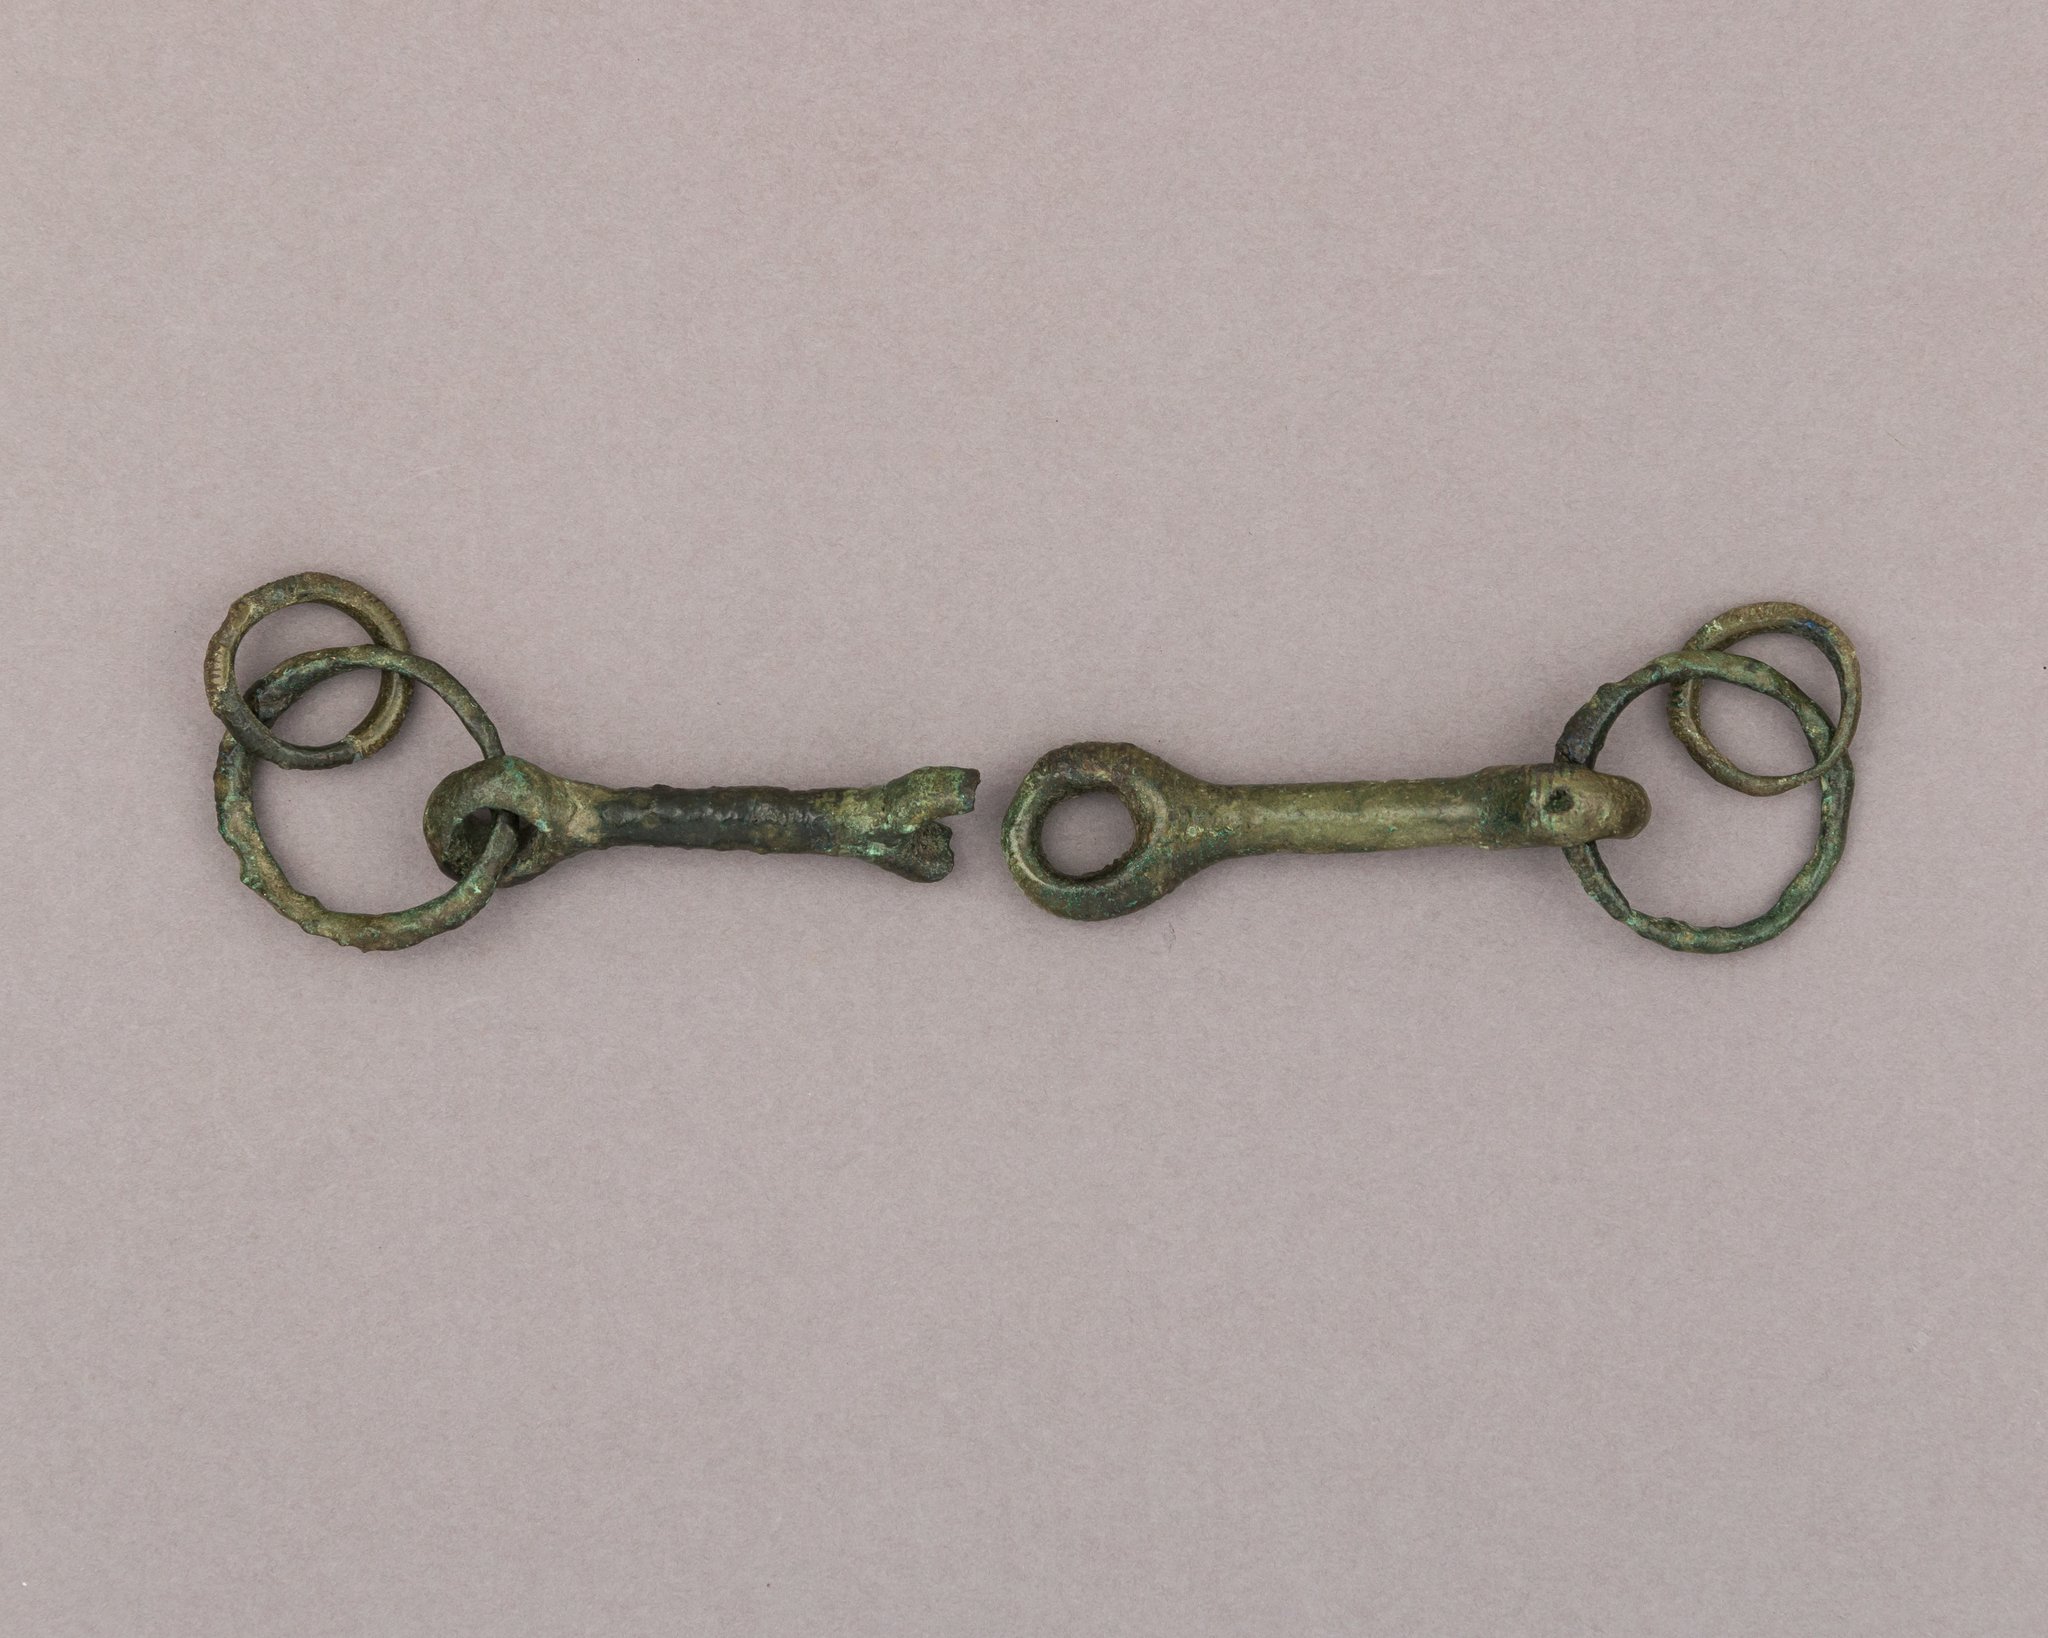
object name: bit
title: Snaffle Bit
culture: european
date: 650-475 BCE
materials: copper alloy